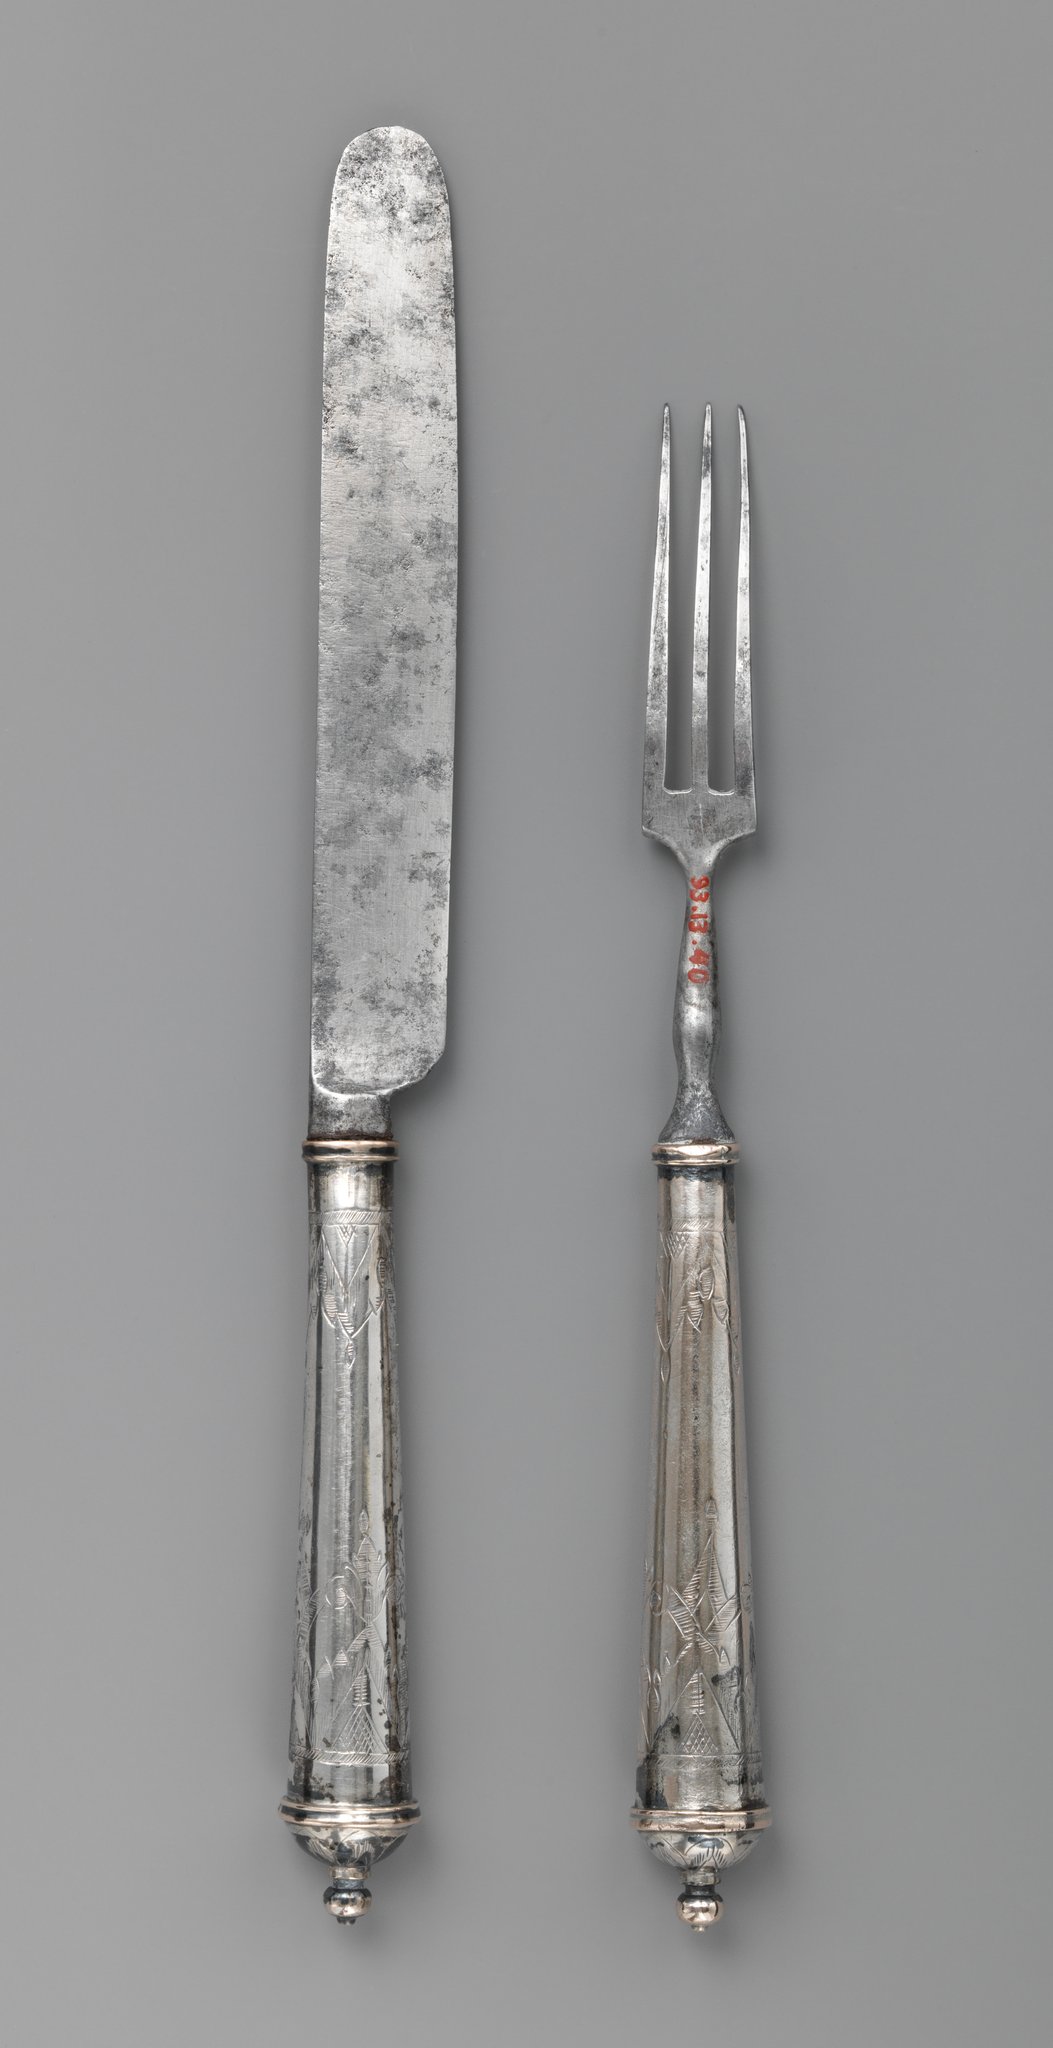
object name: table knife and fork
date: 1701-1800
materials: silver, steel